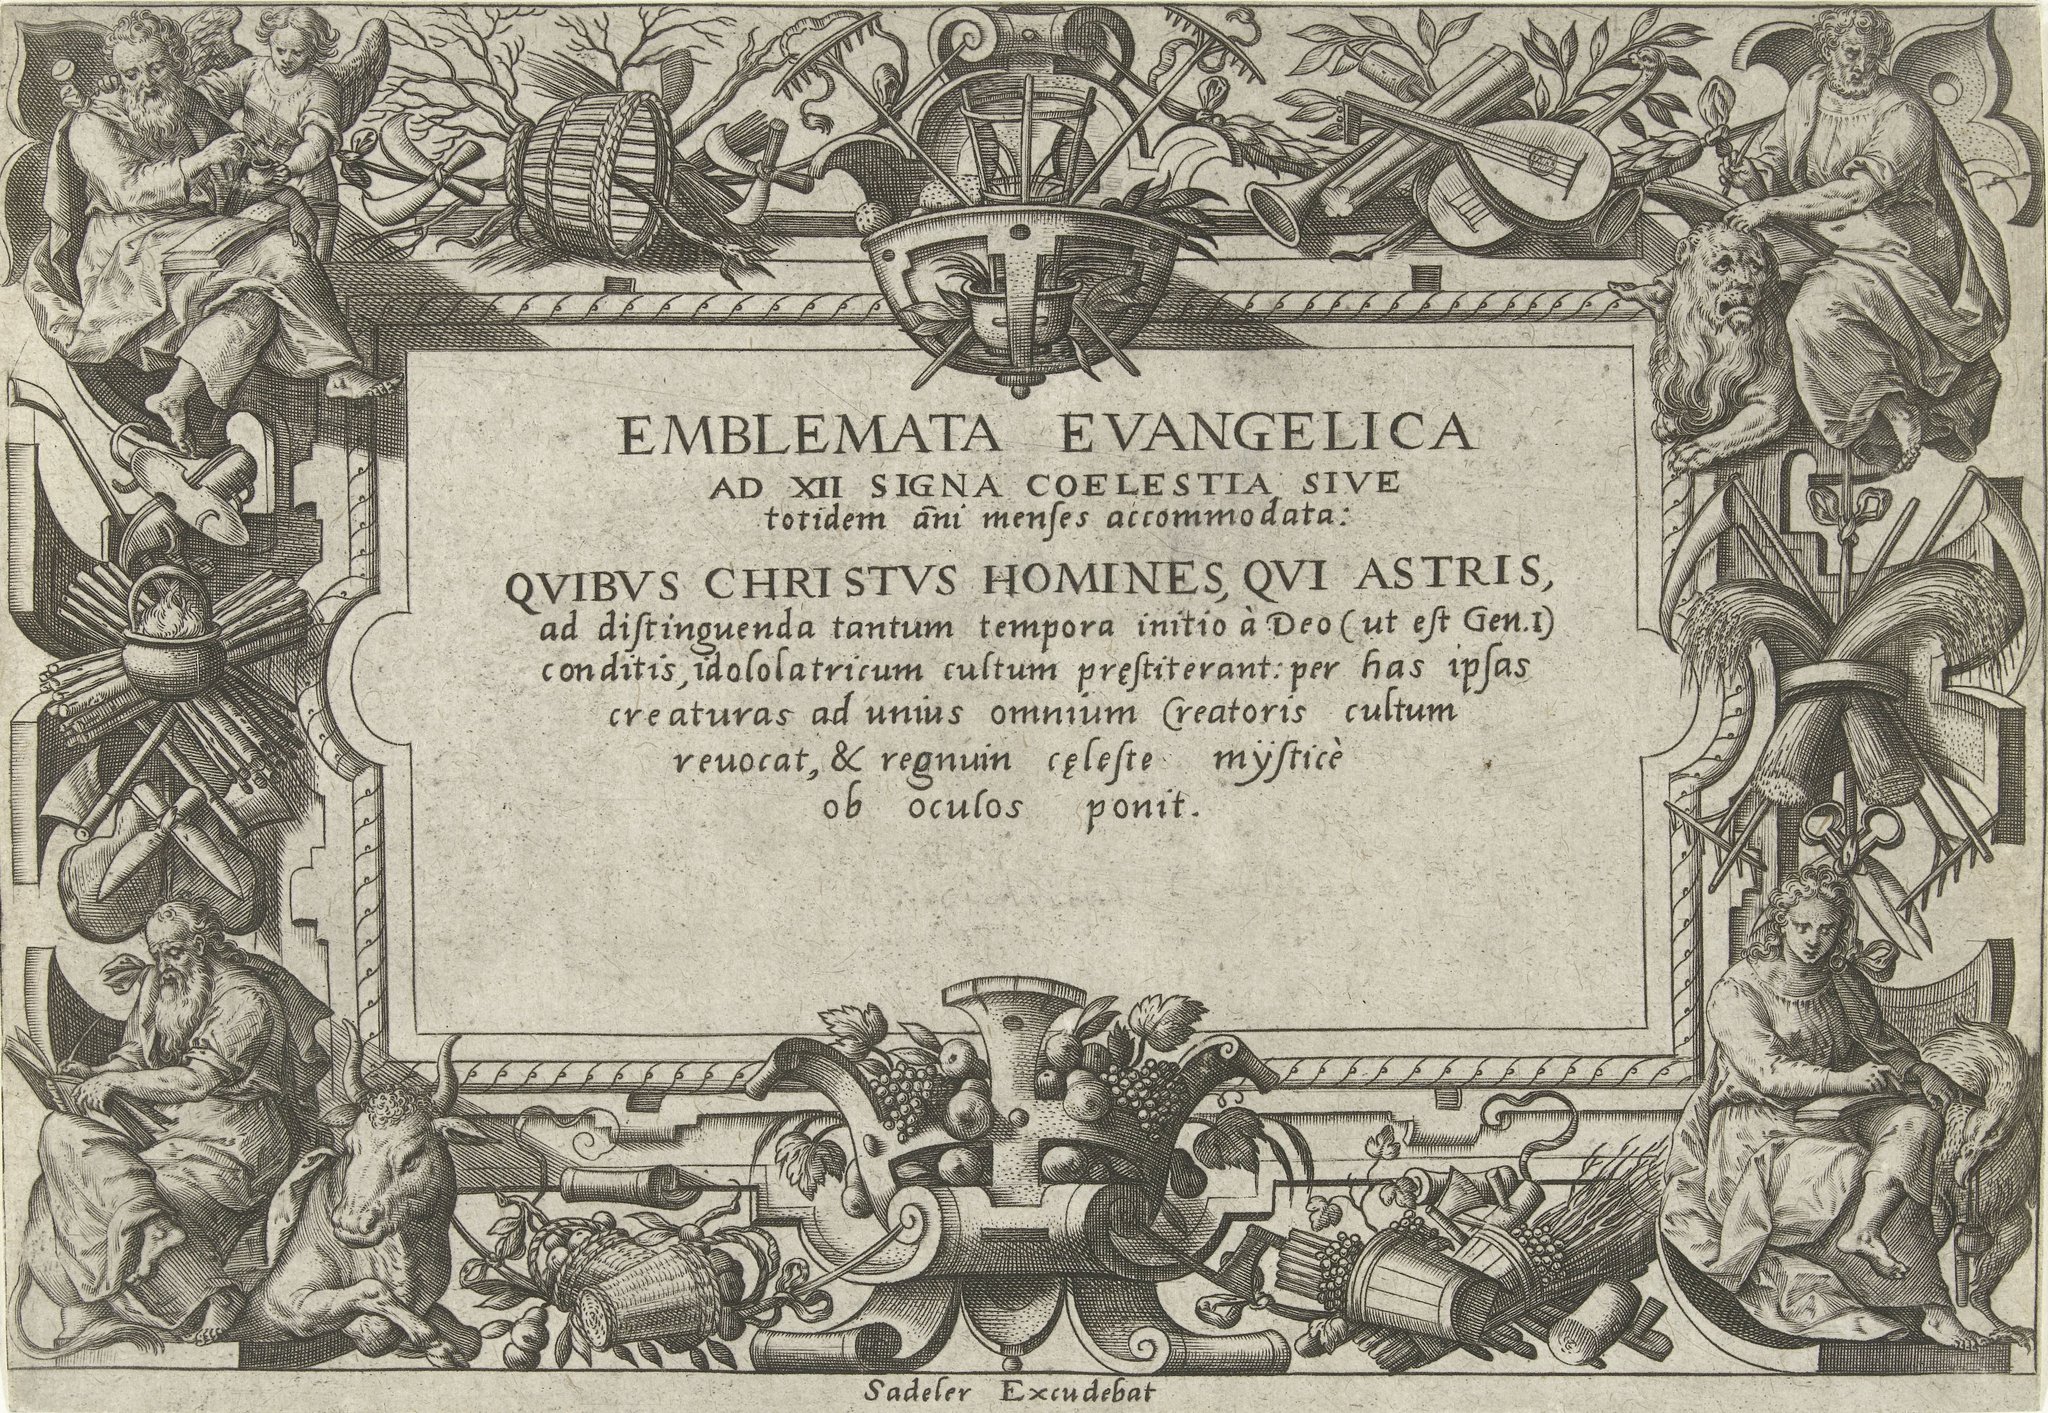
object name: print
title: Het leven van Christus in de twaalf maanden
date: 1585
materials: paper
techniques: engraving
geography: antwerp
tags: fruits and vegetables ~ ornament, the four symbols of the evangelists, 'the apocalyptic beasts'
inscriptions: collector's mark: Lugt 2228, collector's mark: Lugt 2760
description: In een rechthoekig kader de Latijnse titel van de serie. Het kader is versierd met landbouwornamenten die de vier seizoenen afbeelden. In elke hoek een van de evangelisten. Rechtsboven Marcus met de leeuw, linksboven Matteüs met de engel, linksonder Lucas met de os, rechtsonder Johannes met de arend. Dit is de titelprent van een serie over het leven van Christus uitgebeeld in de twaalf maanden van het jaar.